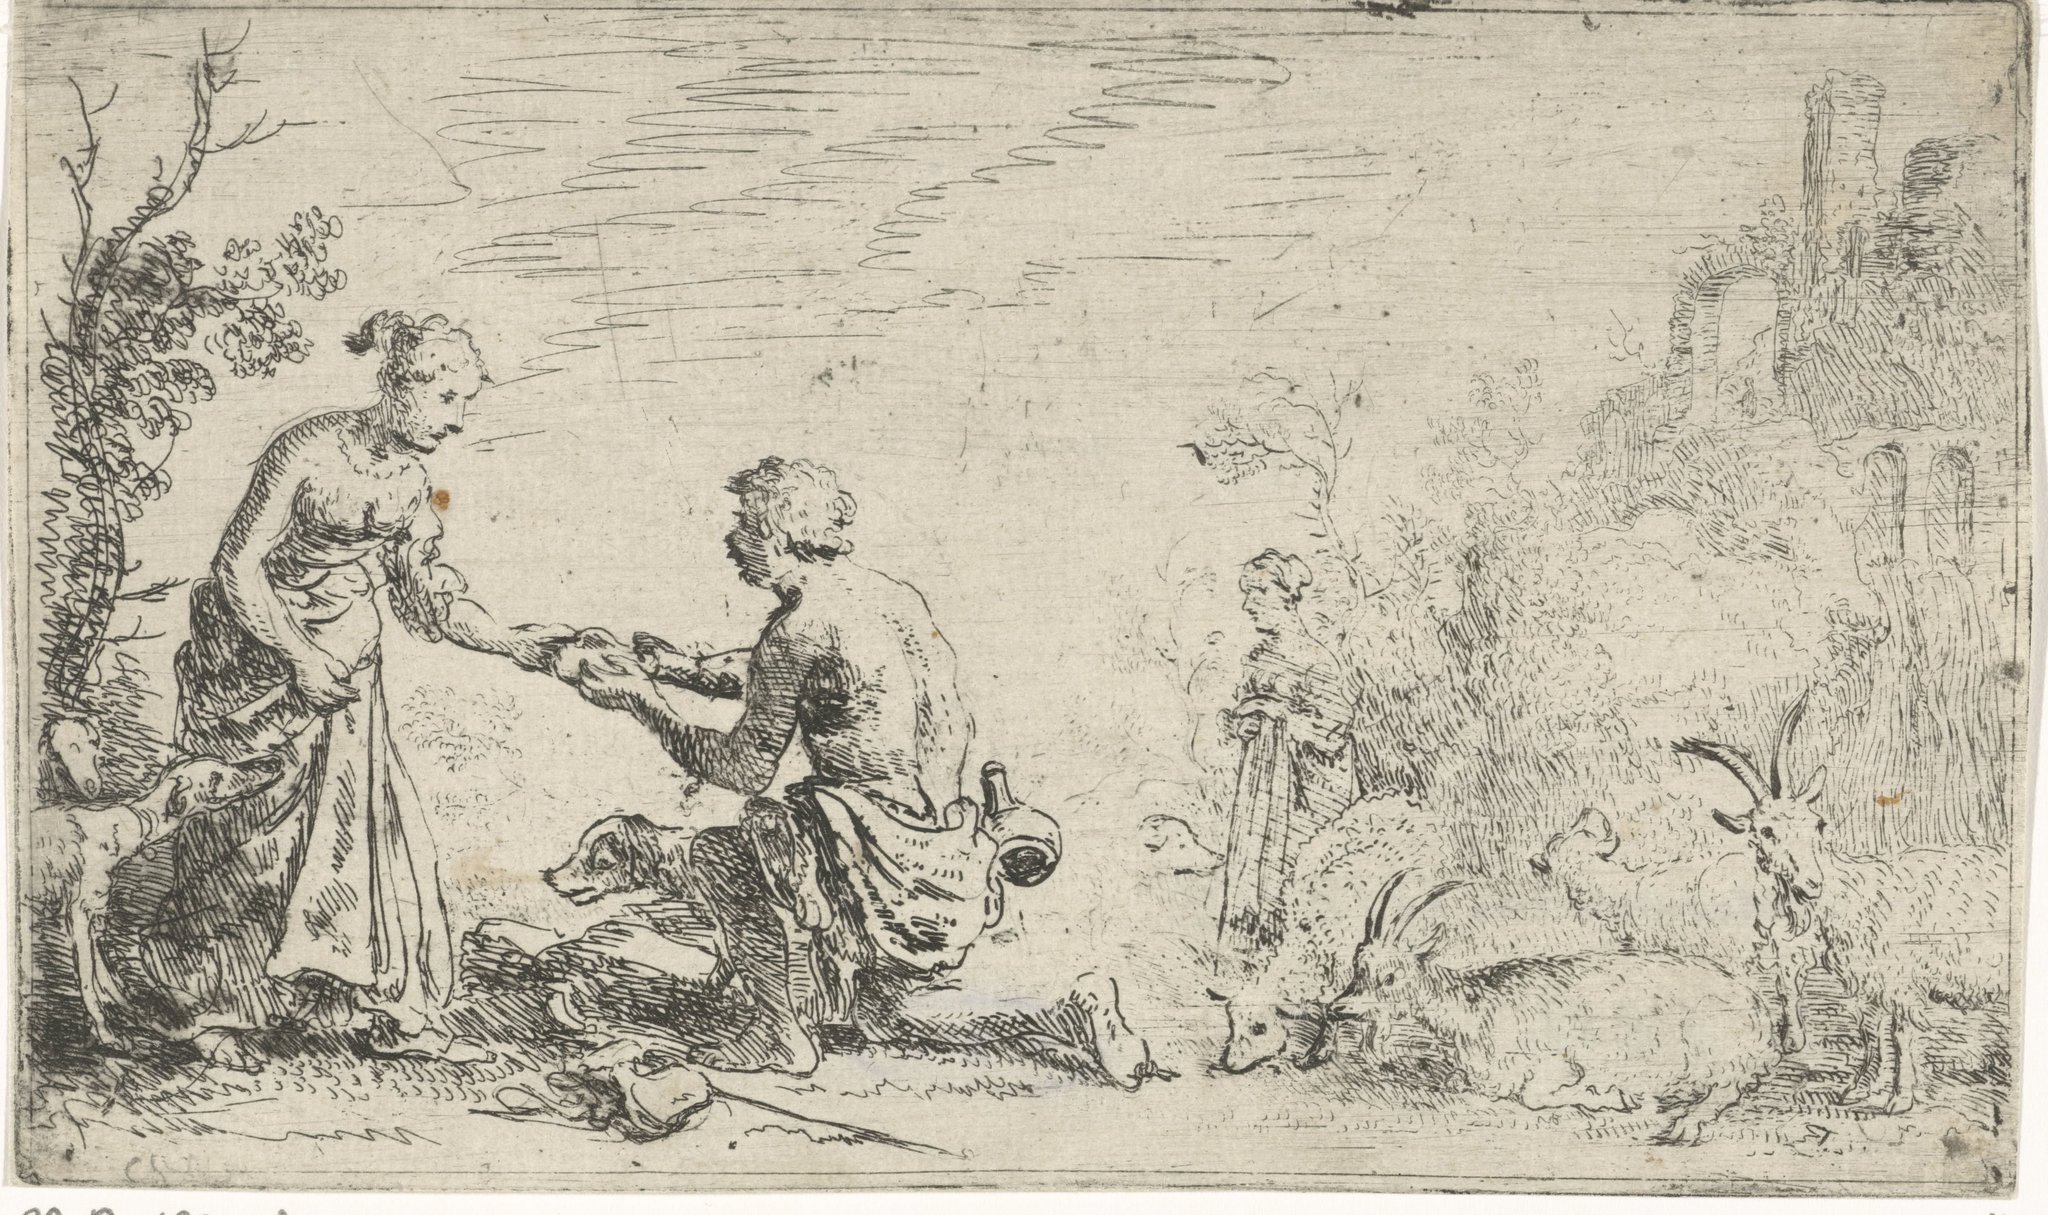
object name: print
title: Granida en Daifilo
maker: claes moeyaert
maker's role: draughtsman, painter, print maker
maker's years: 1592-1655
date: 1612-1655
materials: paper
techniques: etching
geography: amsterdam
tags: herding, herdsman, herdswoman, shepherd, shepherdess, cowherd, etc., kneeling figure, (scenes from) specific works of literature: hooft, granida, dog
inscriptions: collector's mark: Lugt 2228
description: De herder Daifilo knielt voor prinses Granida en biedt haar water aan. Granida, die verdwaalt is tijdens een jachtpartij, heeft jachthonden bij zich. Naast de geiten kijkt Dorilea toe.